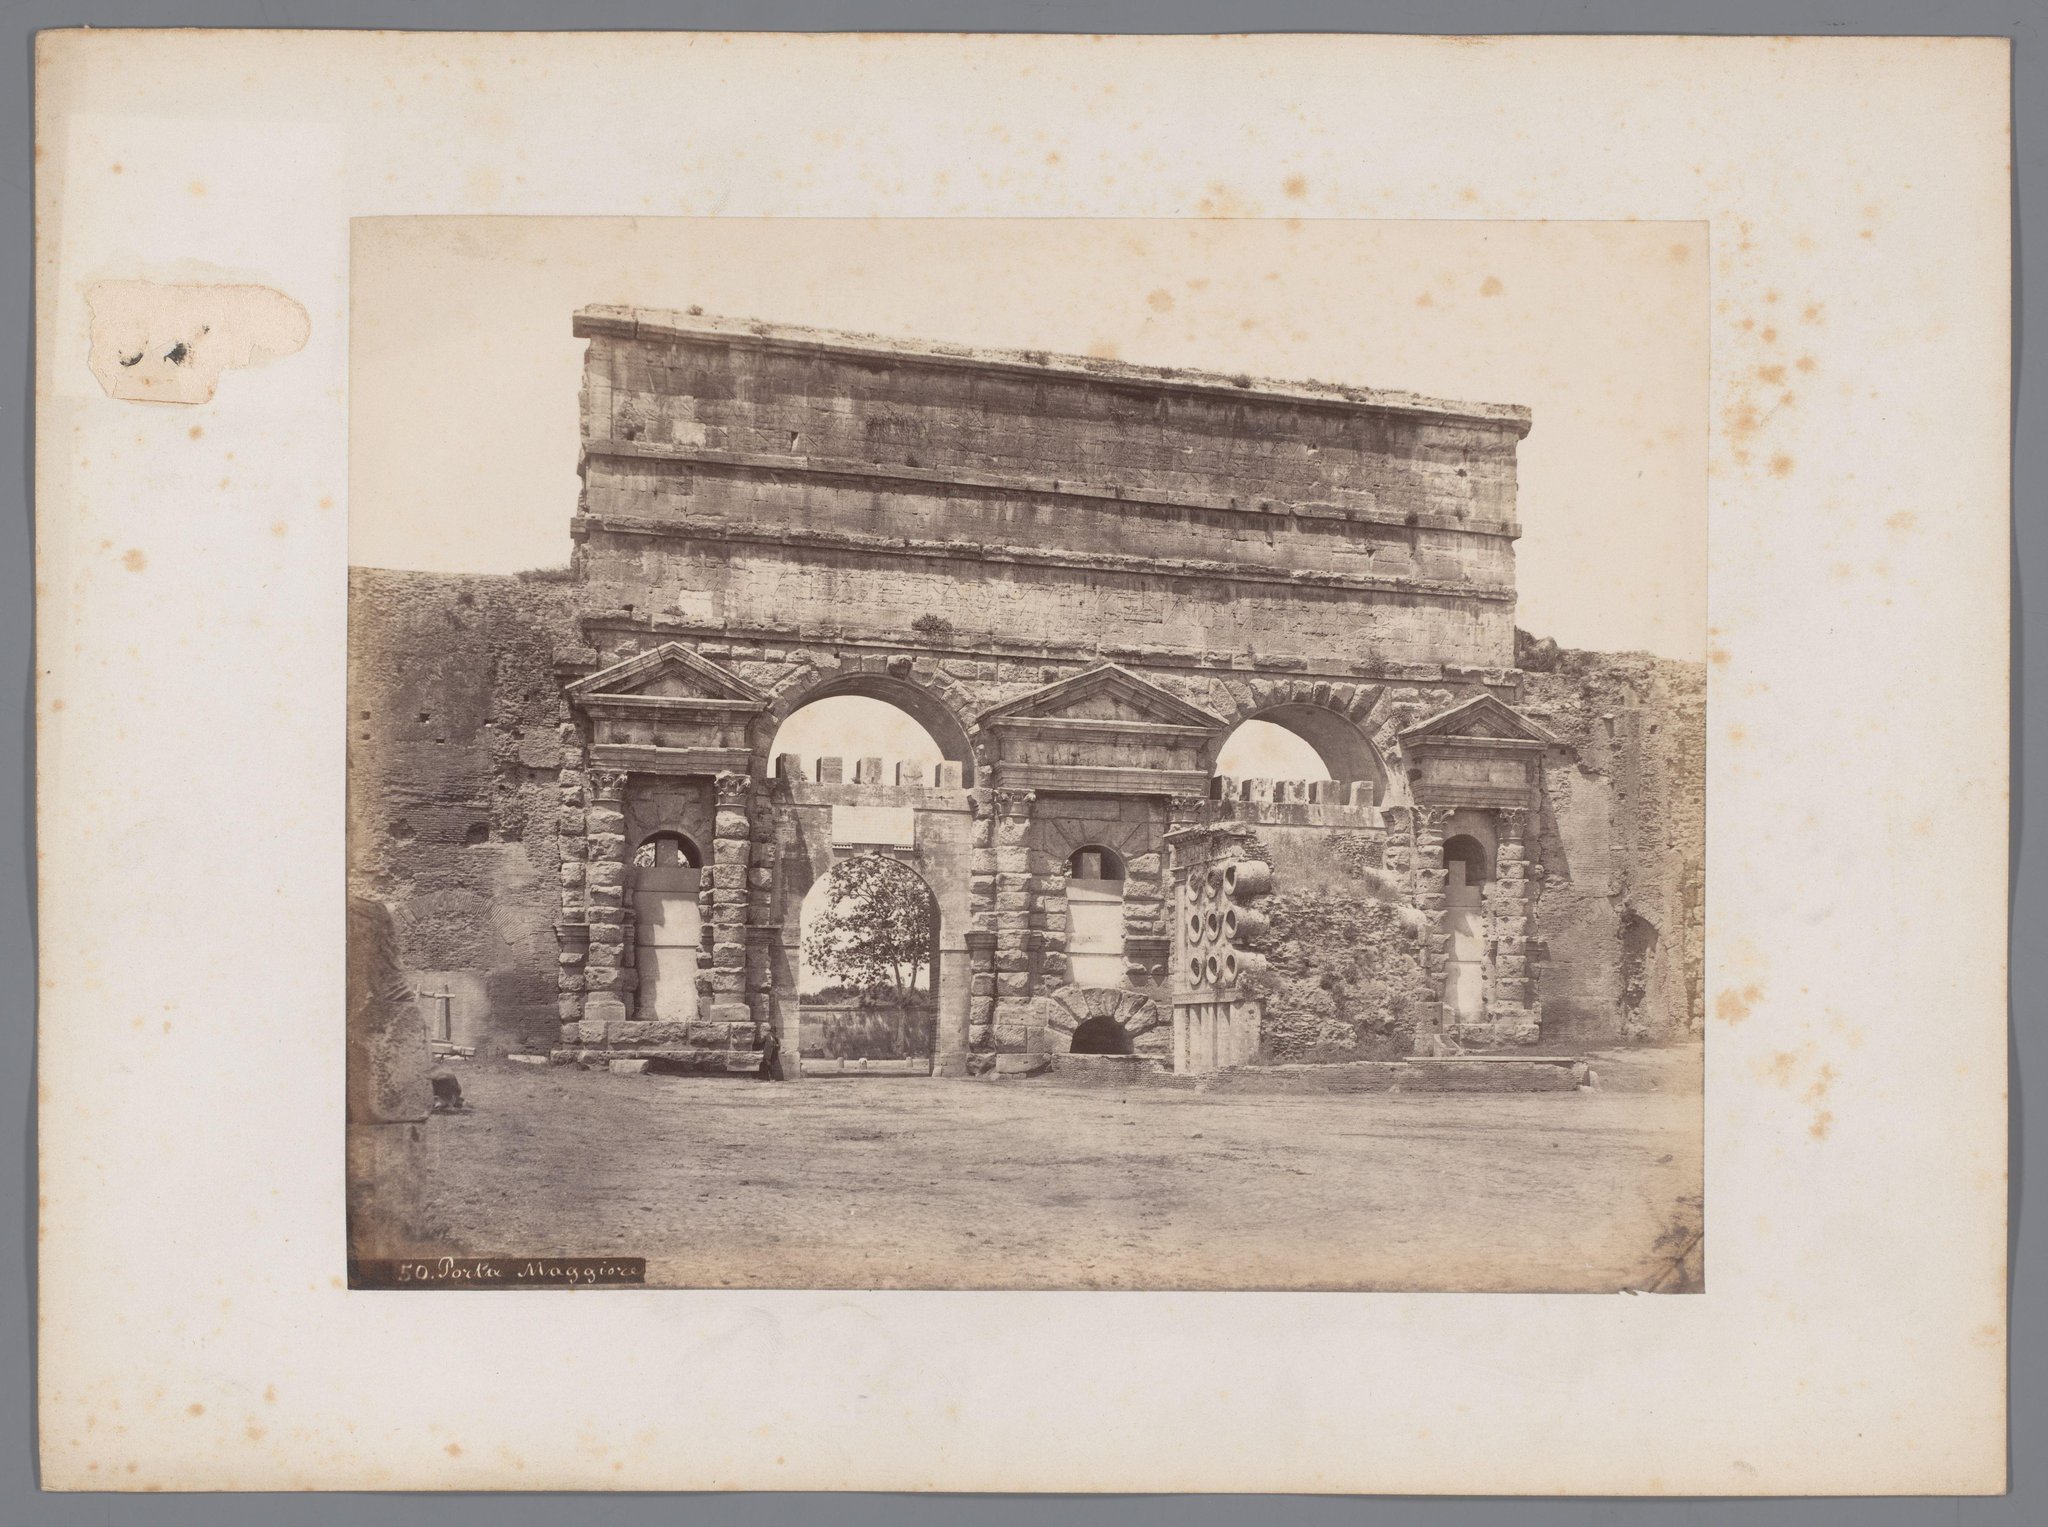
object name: photograph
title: Gezicht op de Porta Maggiore te Rome, Italië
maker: Anonymous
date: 1851-1900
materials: cardboard, paper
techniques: albumen print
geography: rome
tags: city-gate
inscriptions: number: ‘84.’, number: ‘50.’, number: ‘9’